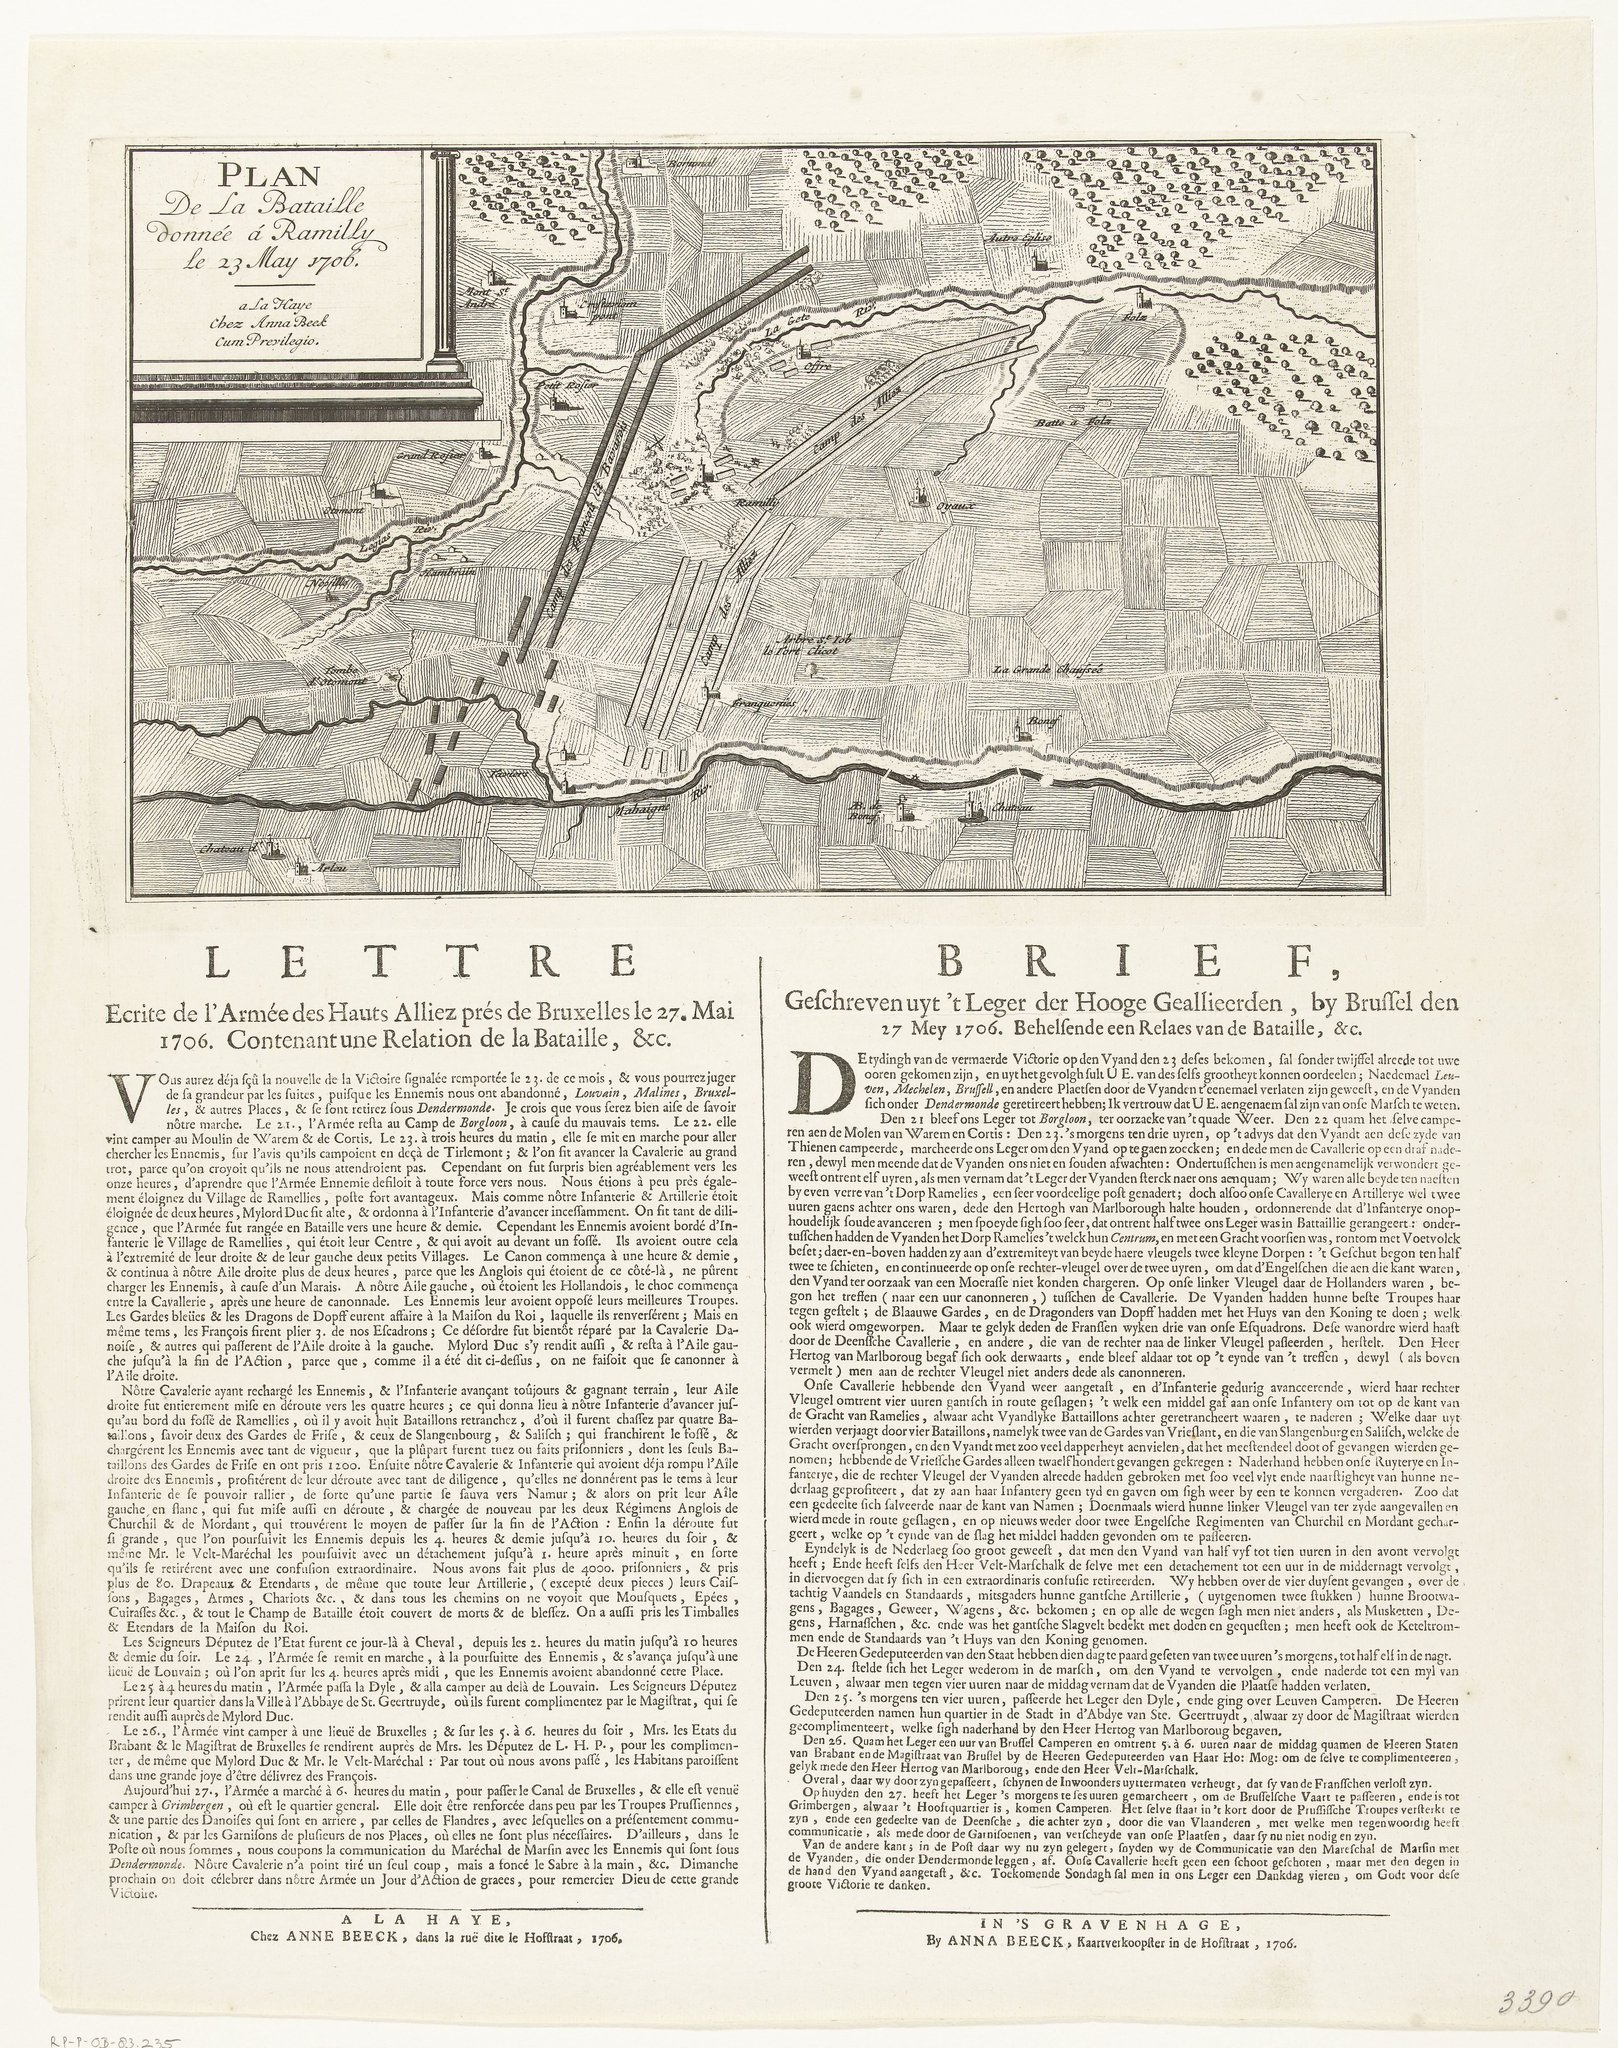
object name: print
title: Plan De La Bataille donnée á Ramilly le 23 May 1706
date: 1706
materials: paper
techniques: etching, letterpress printing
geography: the hague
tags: lyon, paris, françois de neufville (hertog van villeroy), maximiliaan ii emanuel (keurvorst van beieren), john churchill (1e hertog van marlborough), maps of separate countries or regions, battle (+ land forces)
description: Kaart van de slag bij Ramillies tussen de Geallieerden onder de hertog van Marlborough en de Heer van Ouwerkerk en de Fransen en Spanjaarden onder de keurvorst van Beieren en de hertog van Villeroy, 23 mei 1706. Gedrukt op het blad onder de plaat een tekst in de vorm van een brief uit het Geallieerde leger met een relaas van de slag, in 2 kolommen in het Frans en Nederlands.